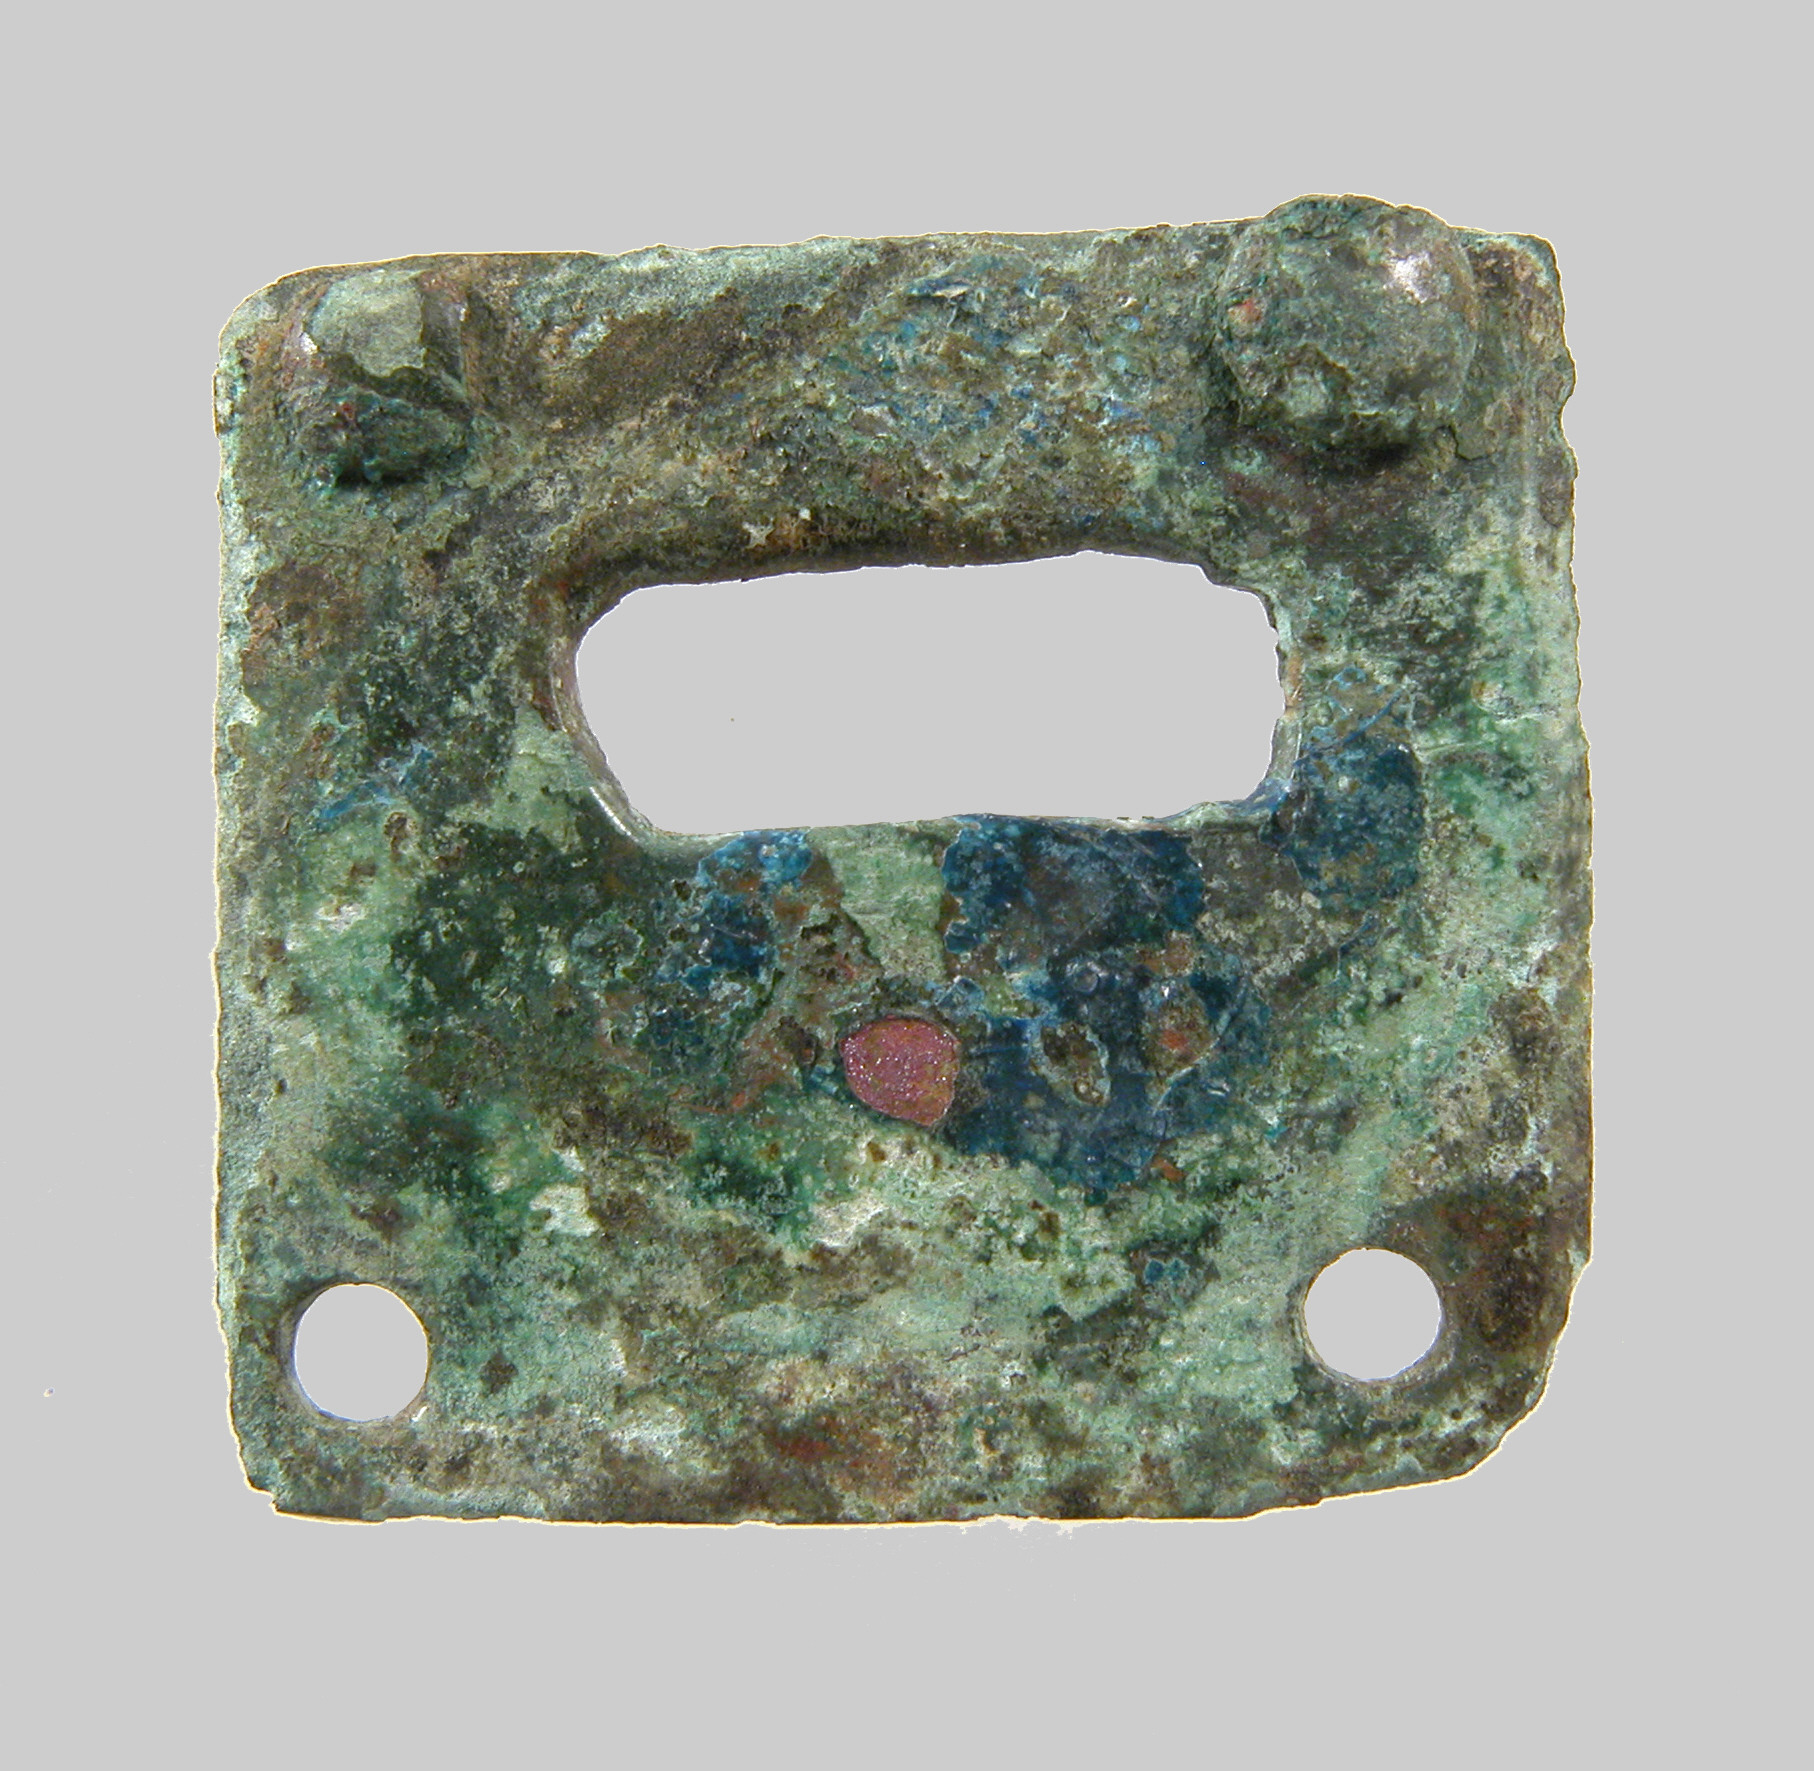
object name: plaque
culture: frankish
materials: copper alloy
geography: germany